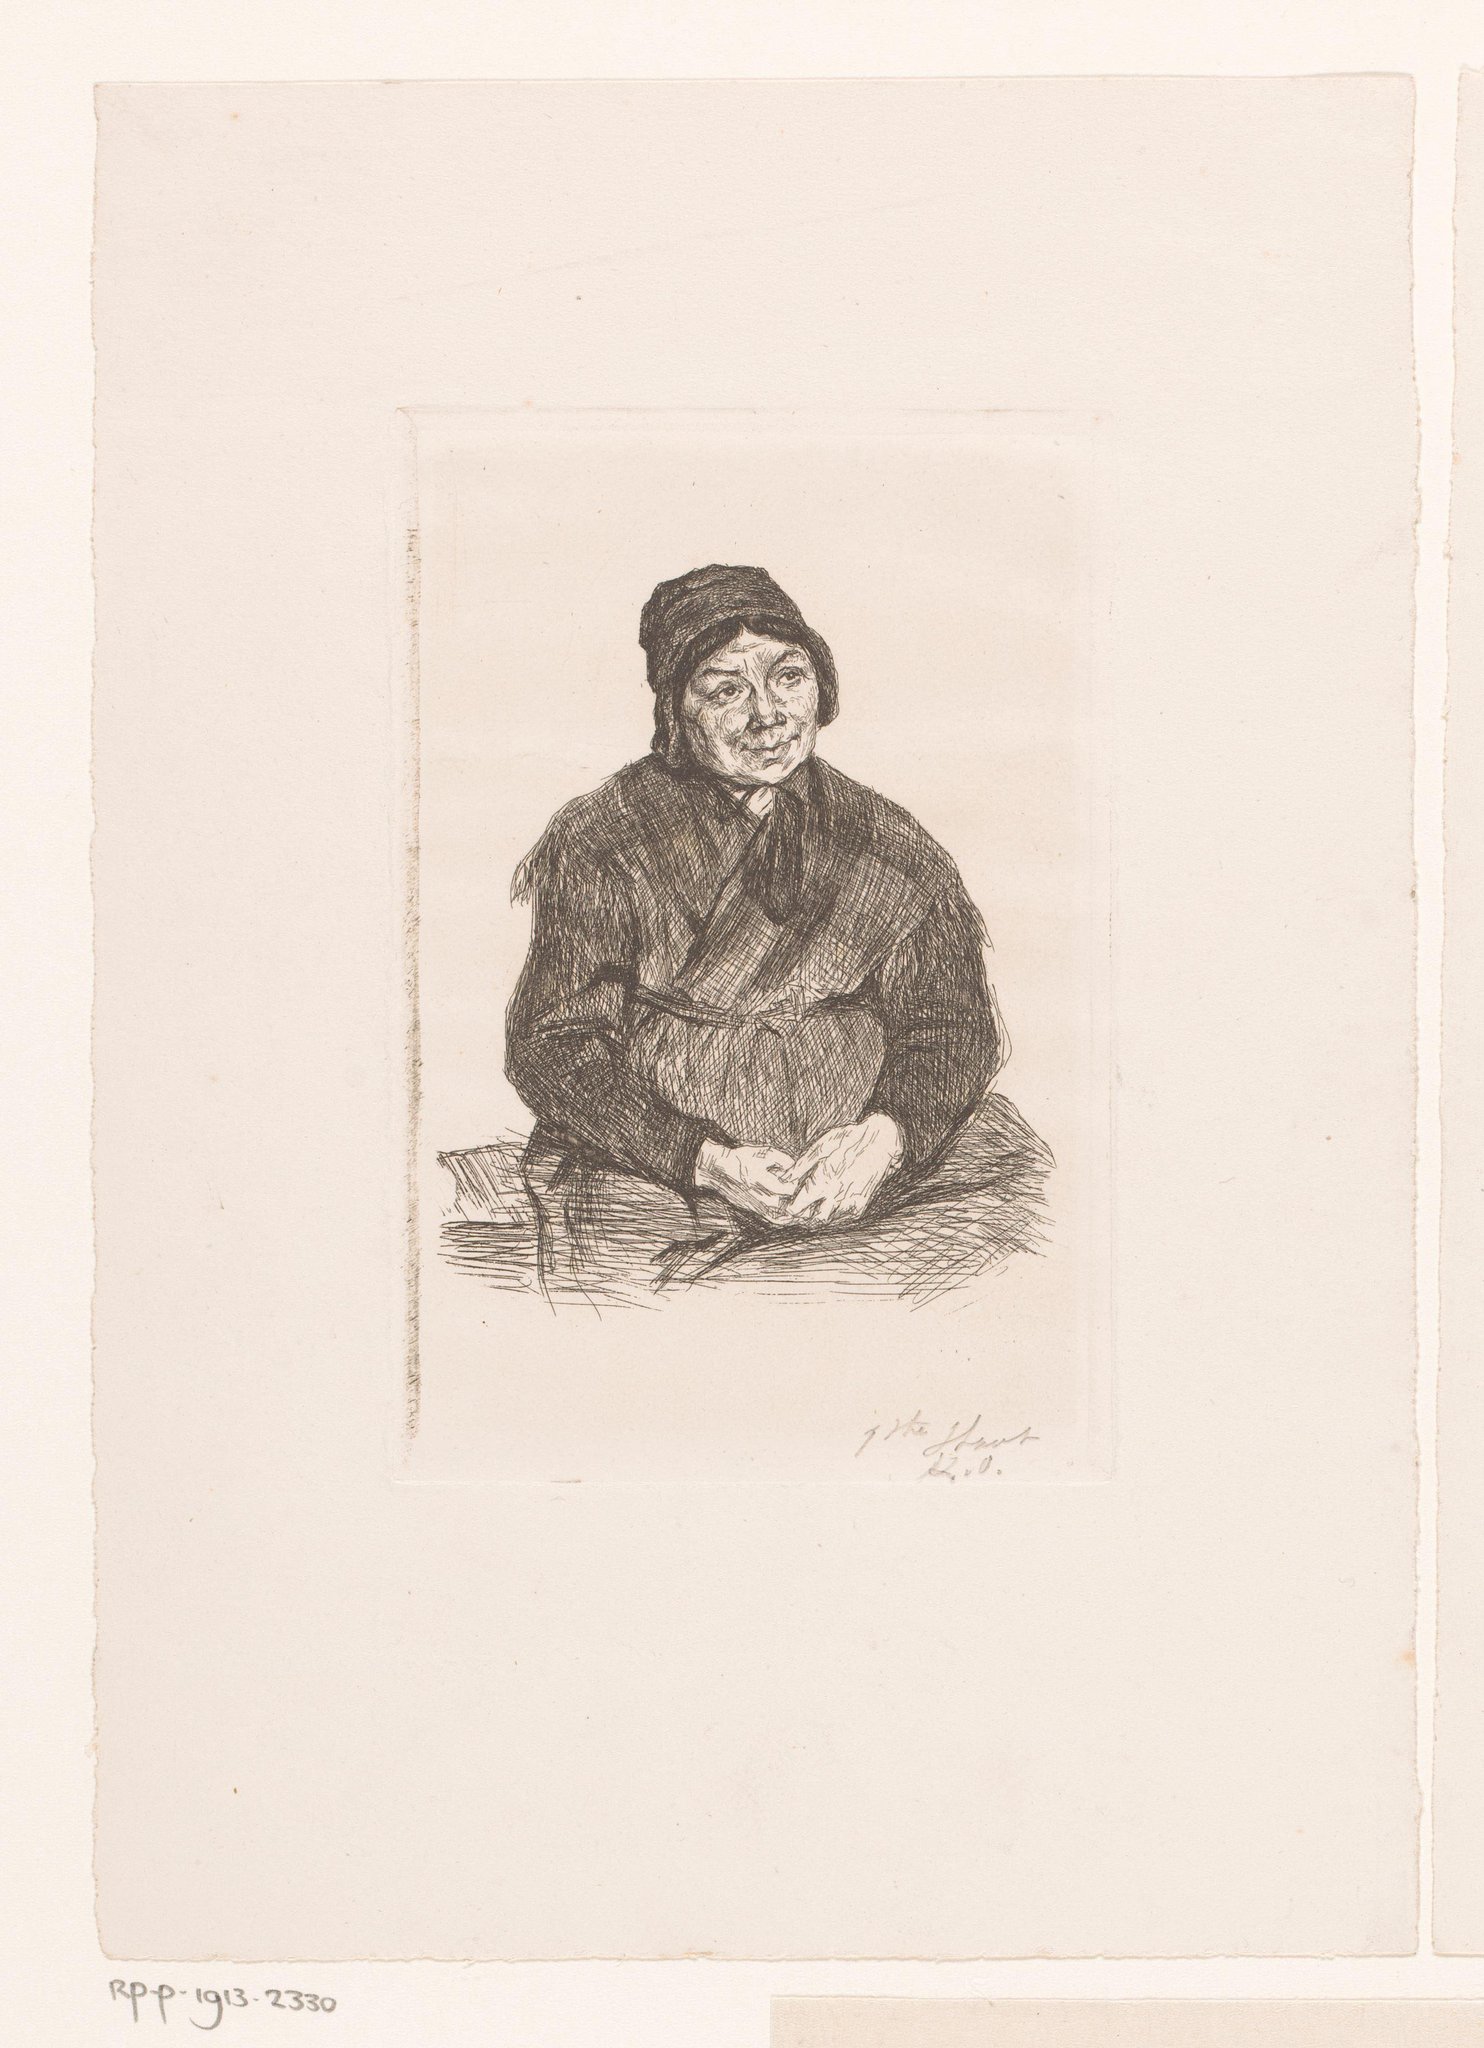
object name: print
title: Zittende vrouw met haar handen in haar schoot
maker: karel ooms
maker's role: print maker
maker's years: 1845-1900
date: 1855-1900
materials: paper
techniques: etching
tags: adult woman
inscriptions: collector's mark: Lugt 2228, annotation: ‘1ste staat’